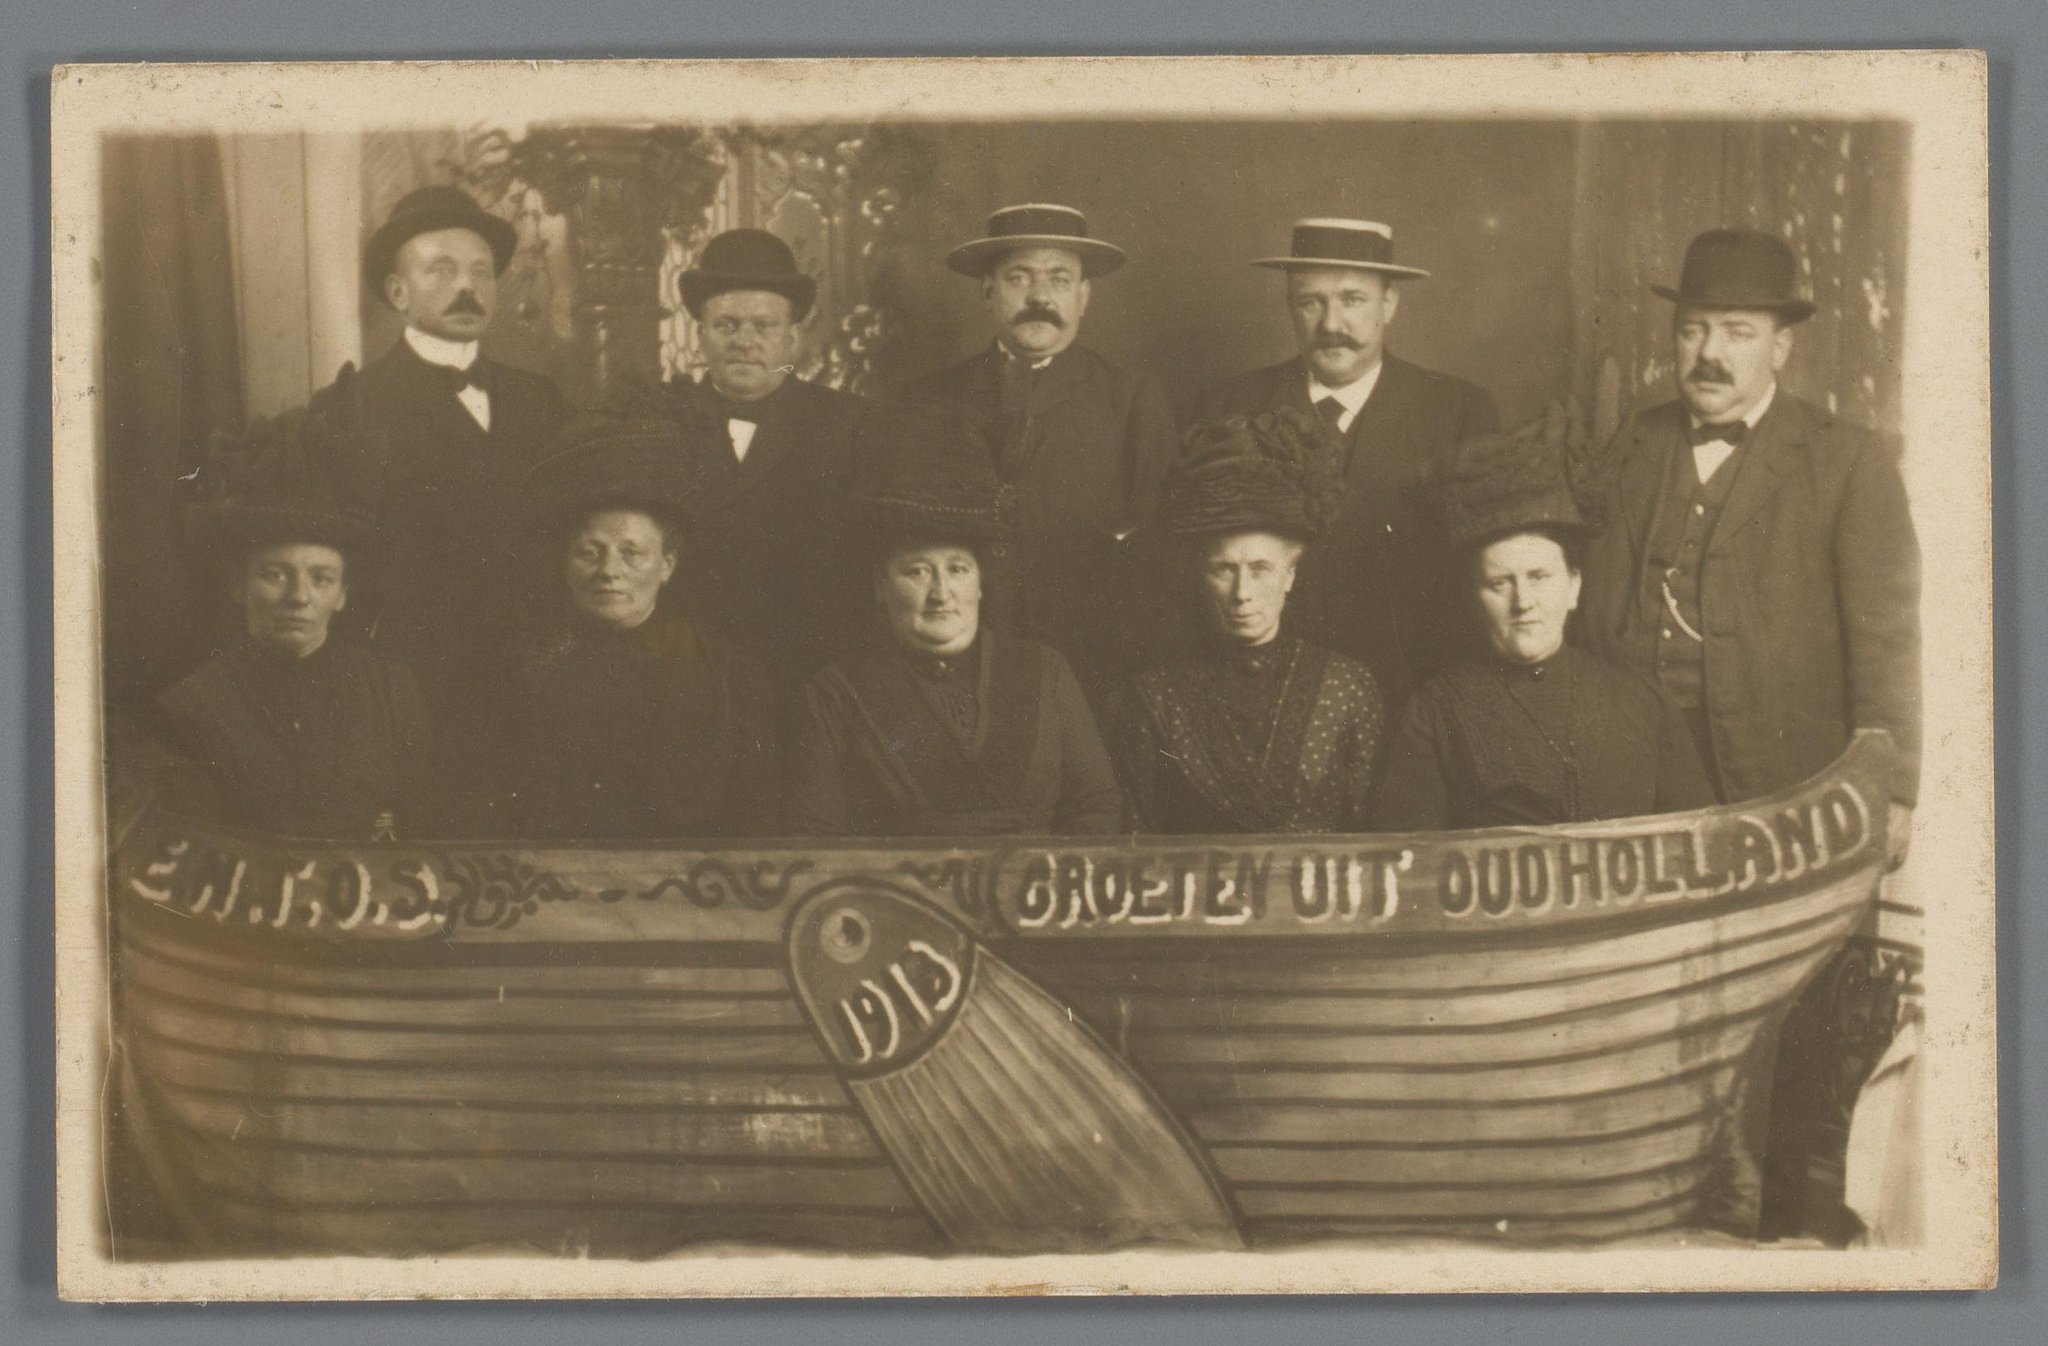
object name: photograph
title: Groepsportret van tien onbekende bezoekers van de Eerste Nederlandse Tentoonstelling op Scheepvaartgebied, in decor met geschilderde boot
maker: Anonymous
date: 1913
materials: paper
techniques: gelatin silver print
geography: amsterdam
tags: anonymous historical persons portrayed in a group, in a group-portrait, amsterdam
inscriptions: inscription: ‘Uw Portret op Briefkaart/ Direct mede te nemen/ E.N.T.O.S./ Oud Amsterdam./ t/o Ober Bayern.’